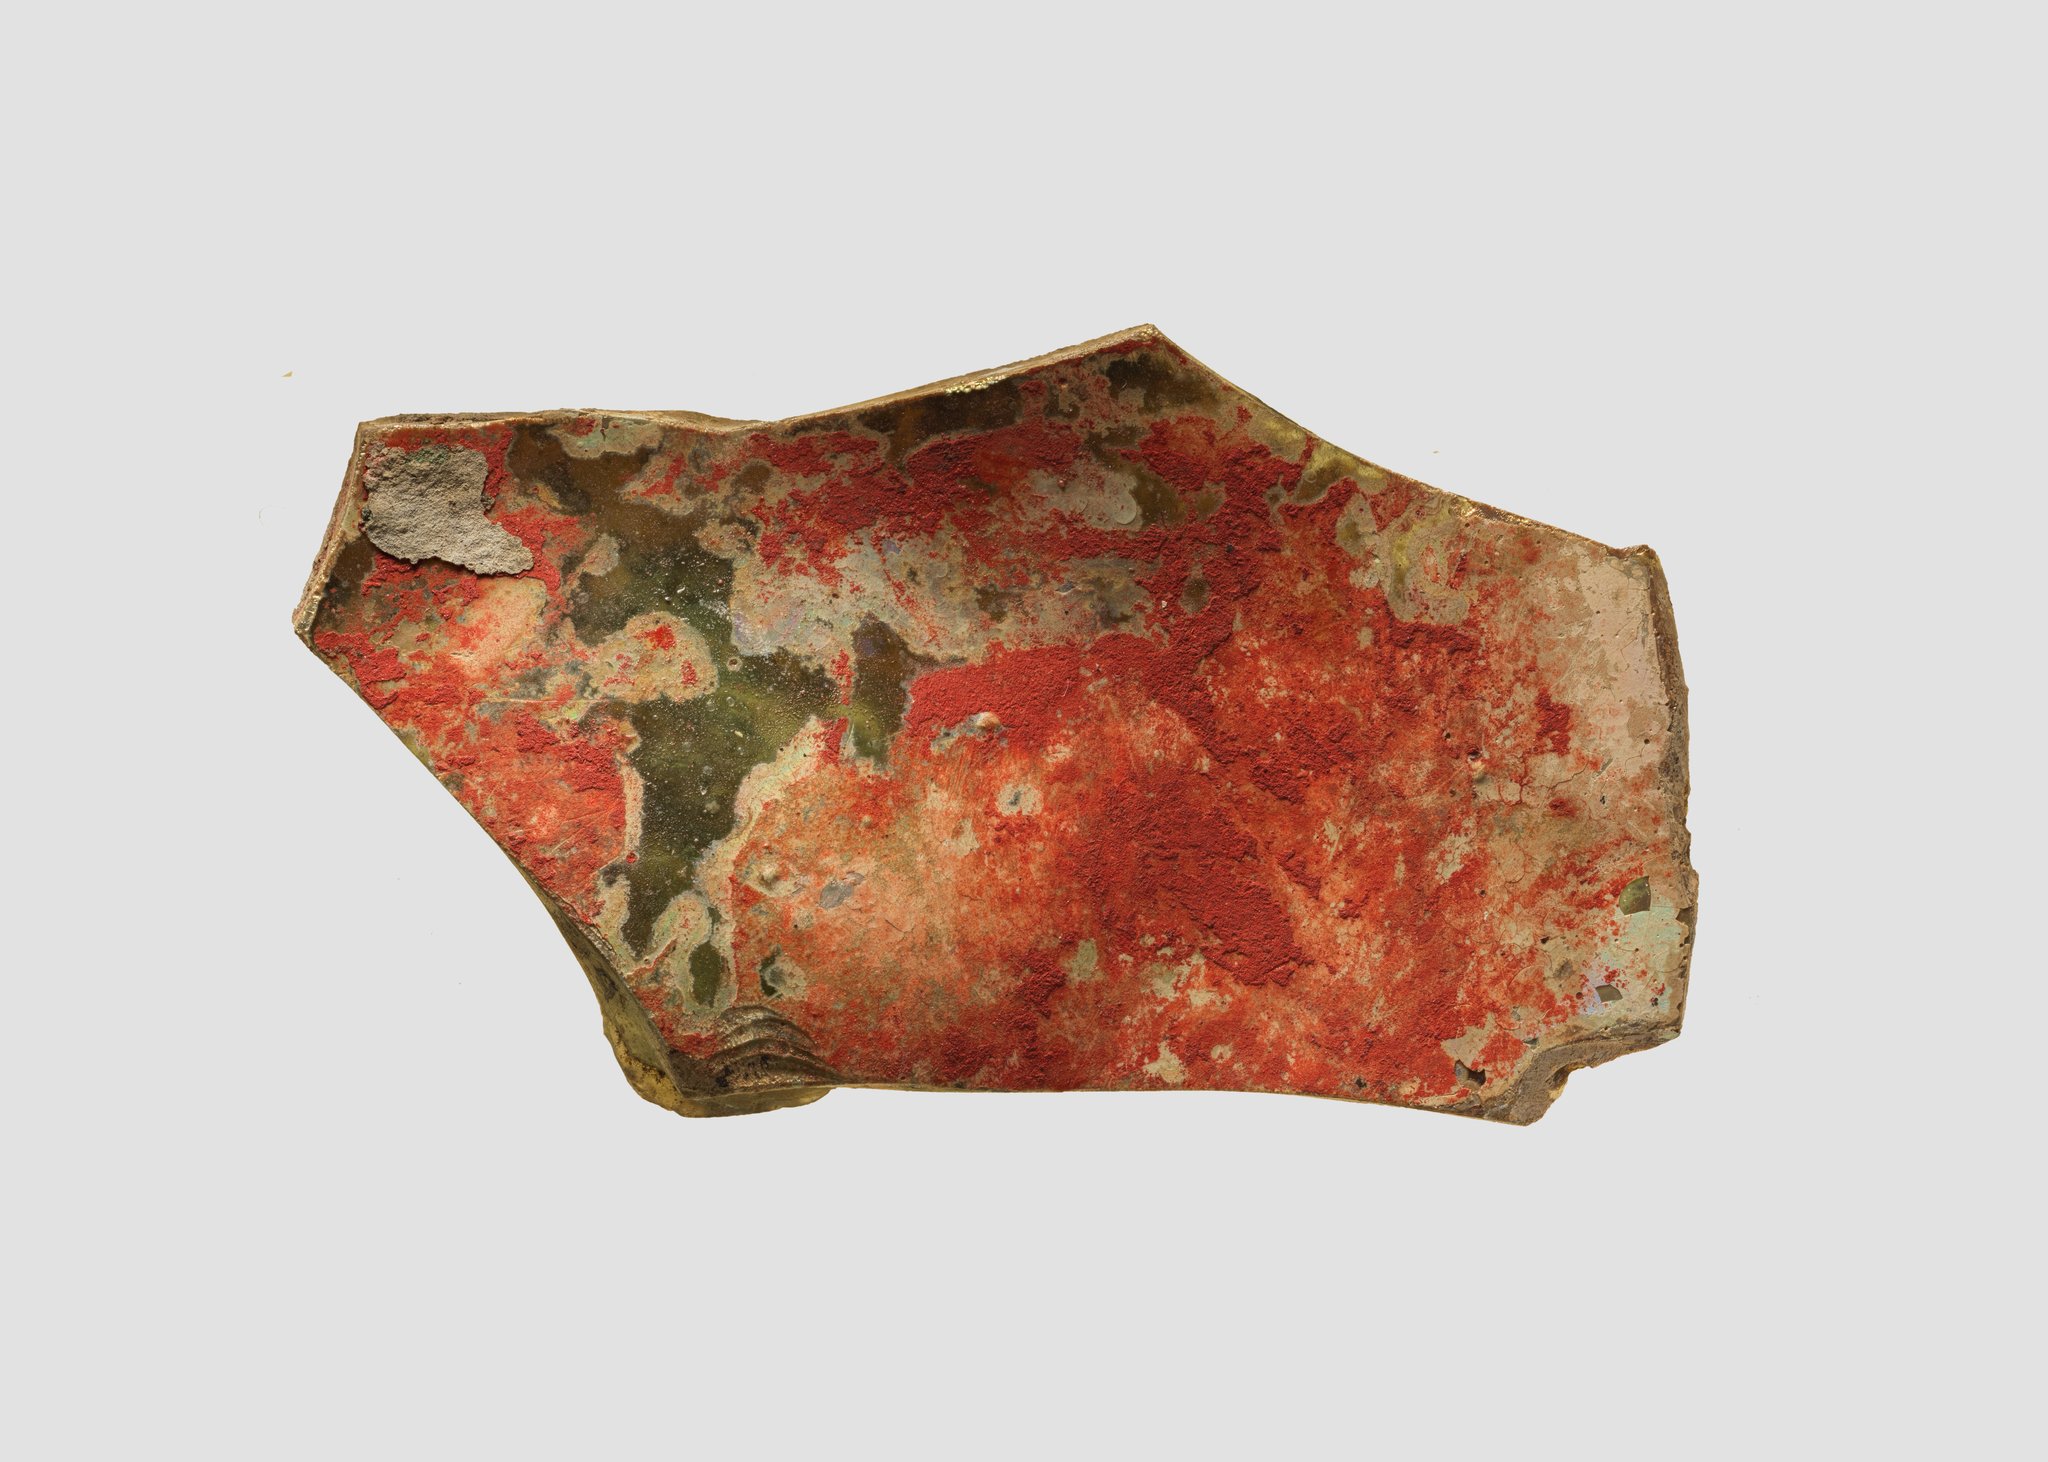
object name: glass vessel fragment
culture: sasanian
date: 201-700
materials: glass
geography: mesopotamia